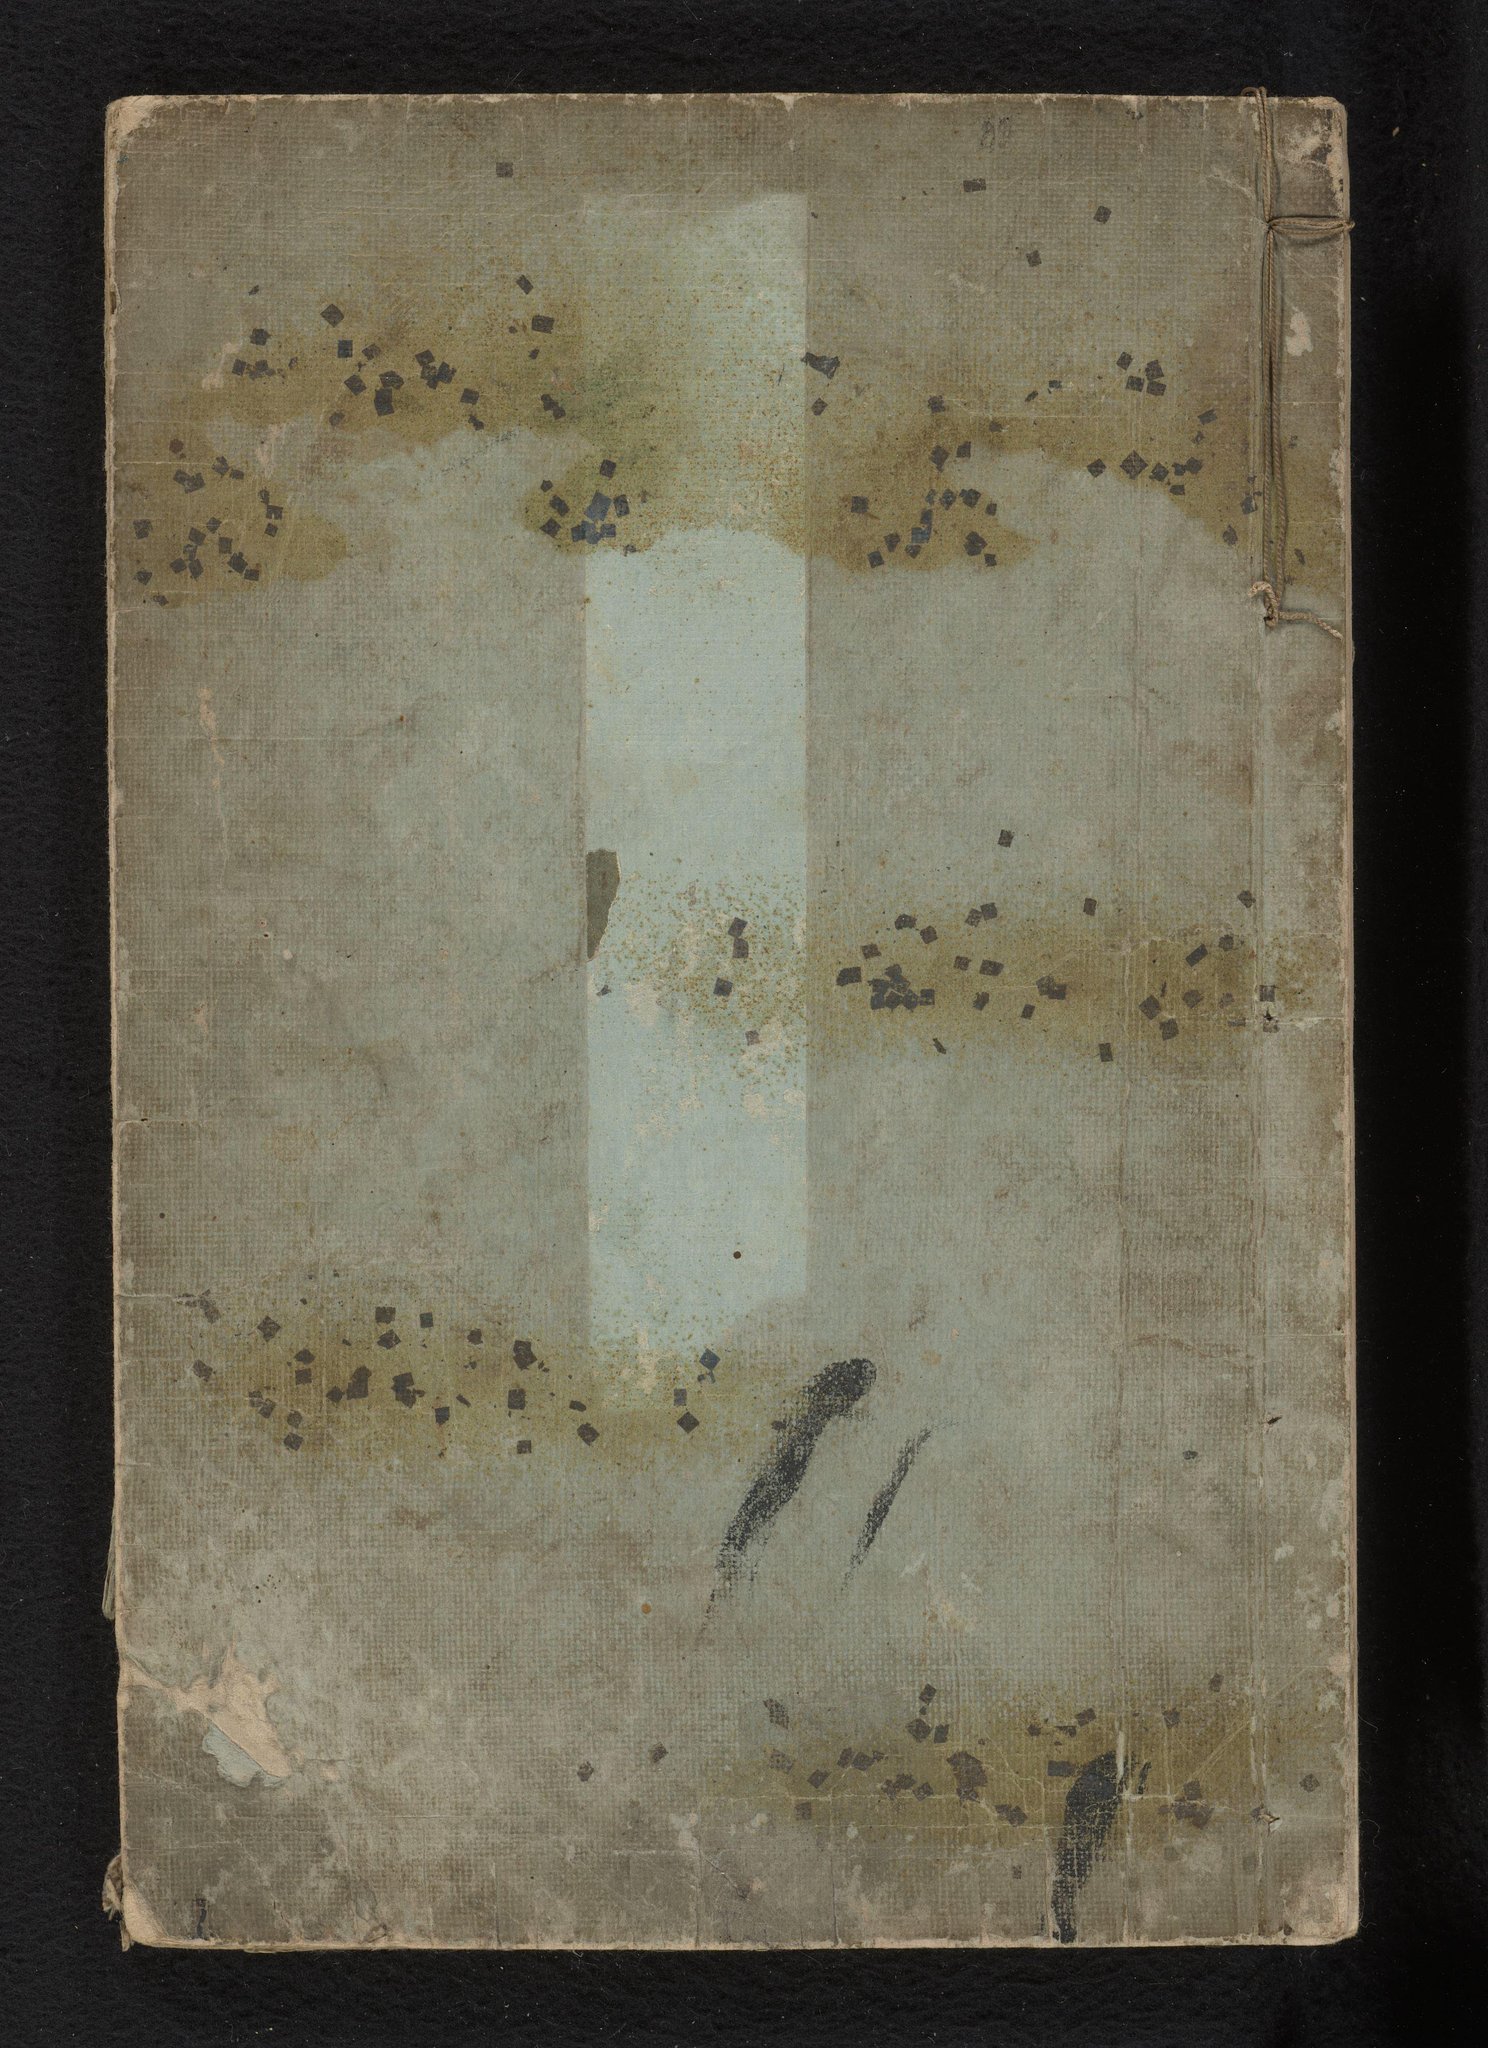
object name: book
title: Seiro bijin awase sugata kagami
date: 1776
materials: paper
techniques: woodcut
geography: edo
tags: courtesan, hetaera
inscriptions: date